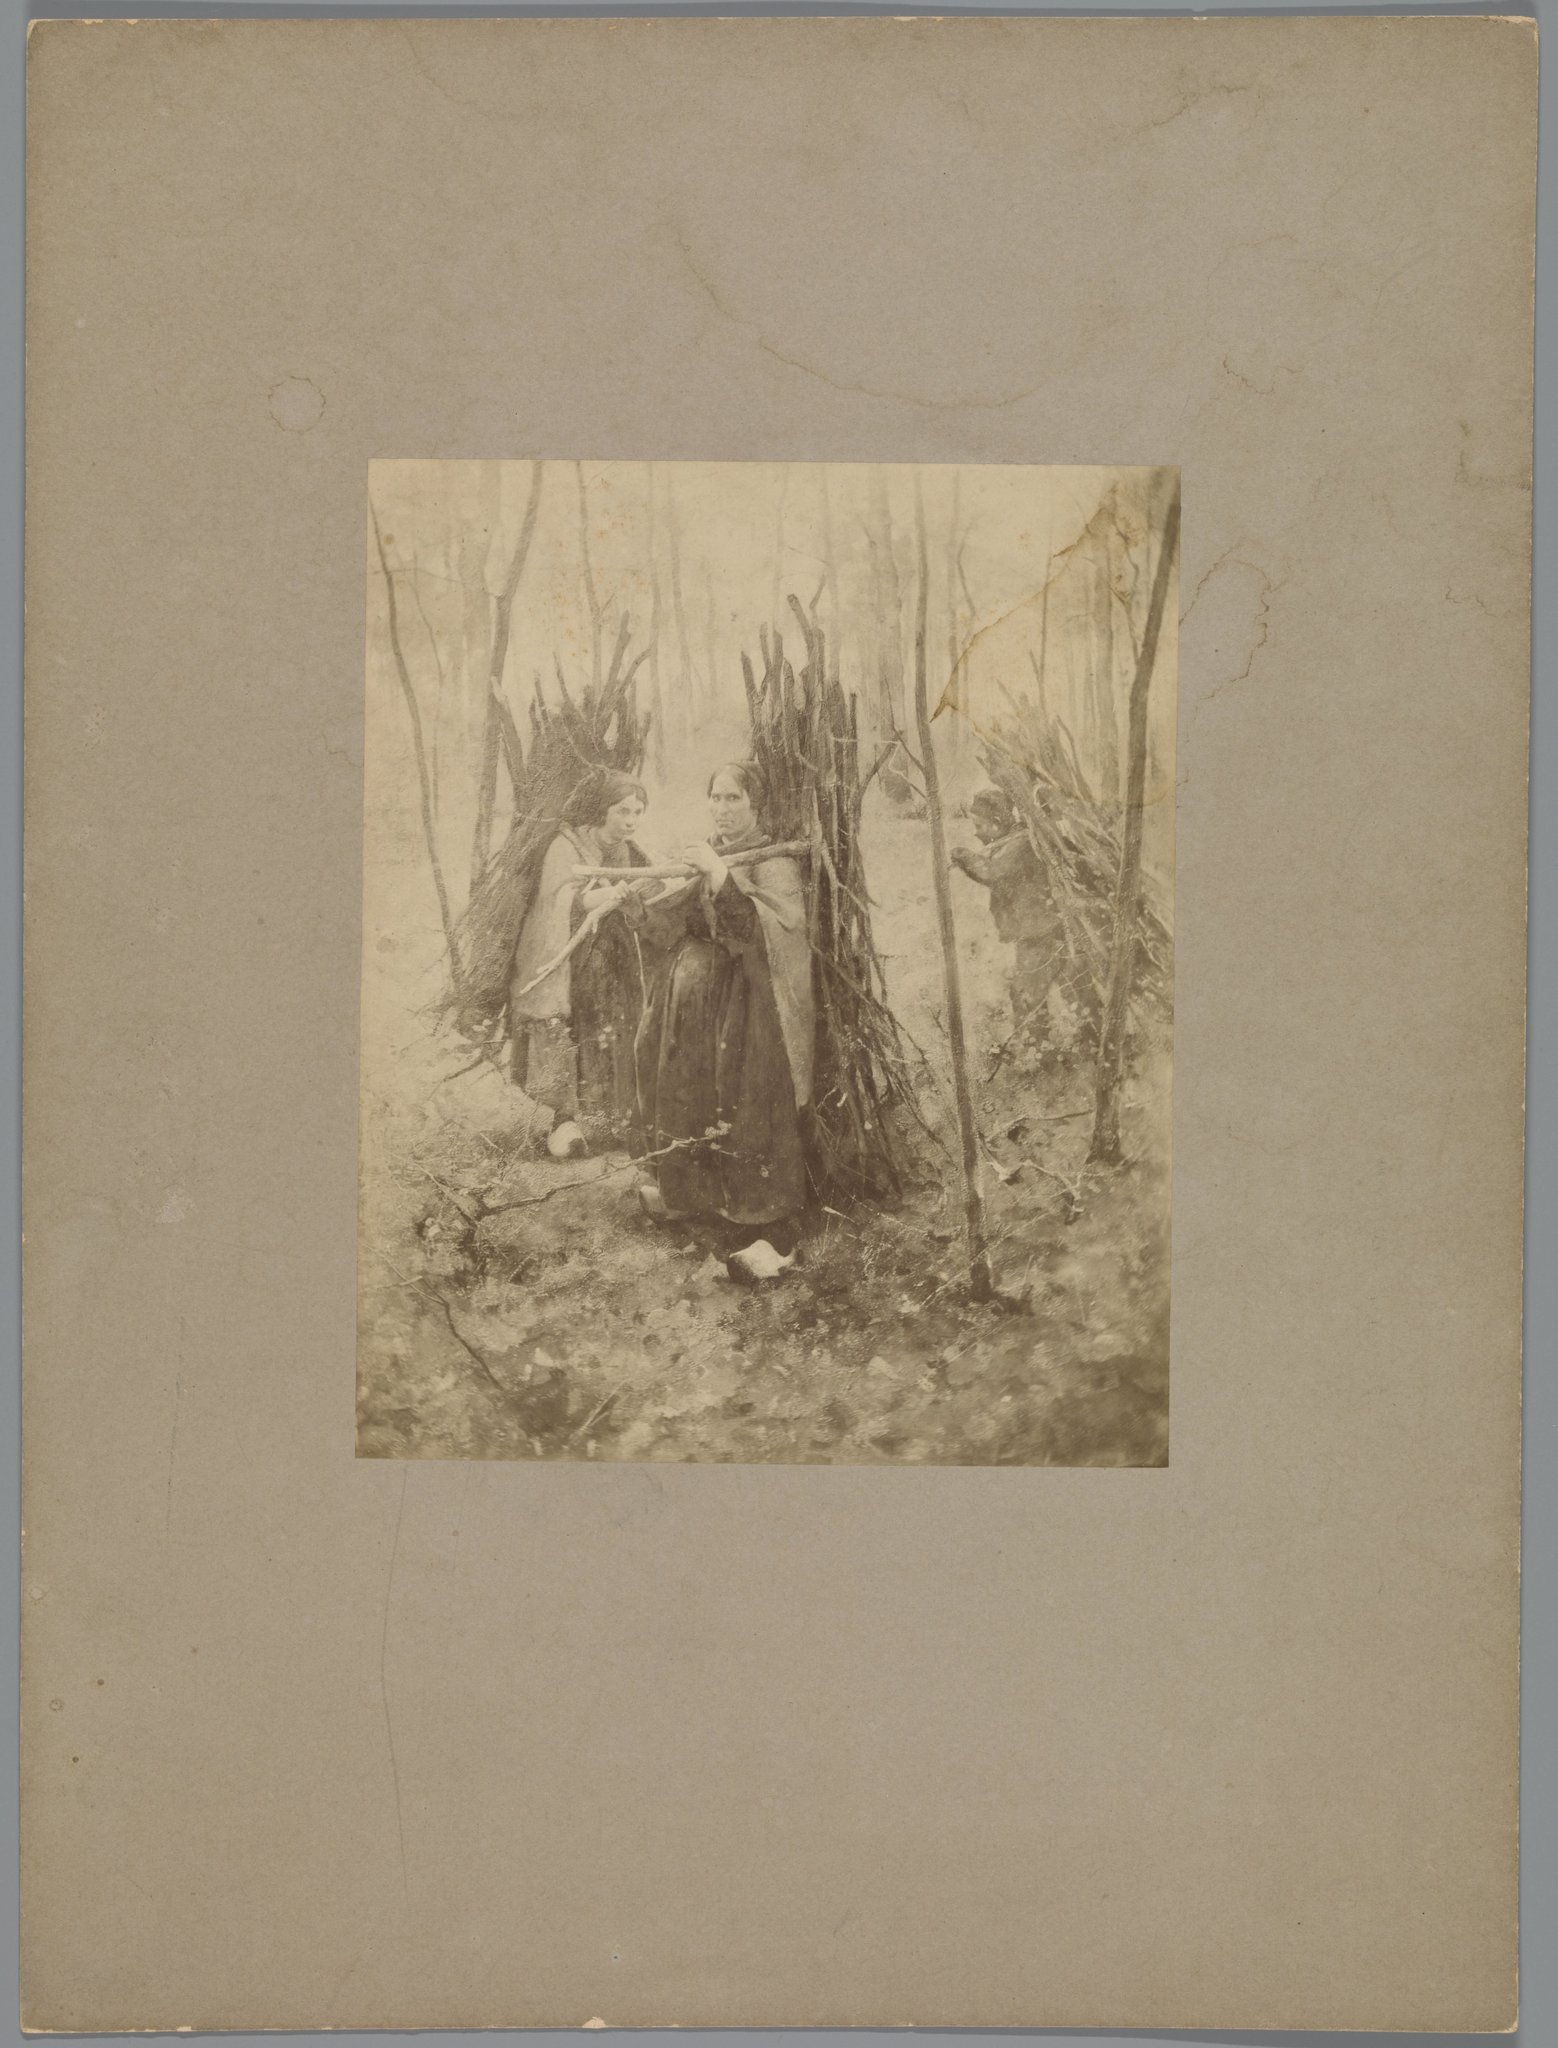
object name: photograph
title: Reproductie naar een schilderij van Willem Witsen van twee vrouwen en een kind met takken op de rug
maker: Anonymous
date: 1860-1915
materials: cardboard, paper, photographic support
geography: netherlands